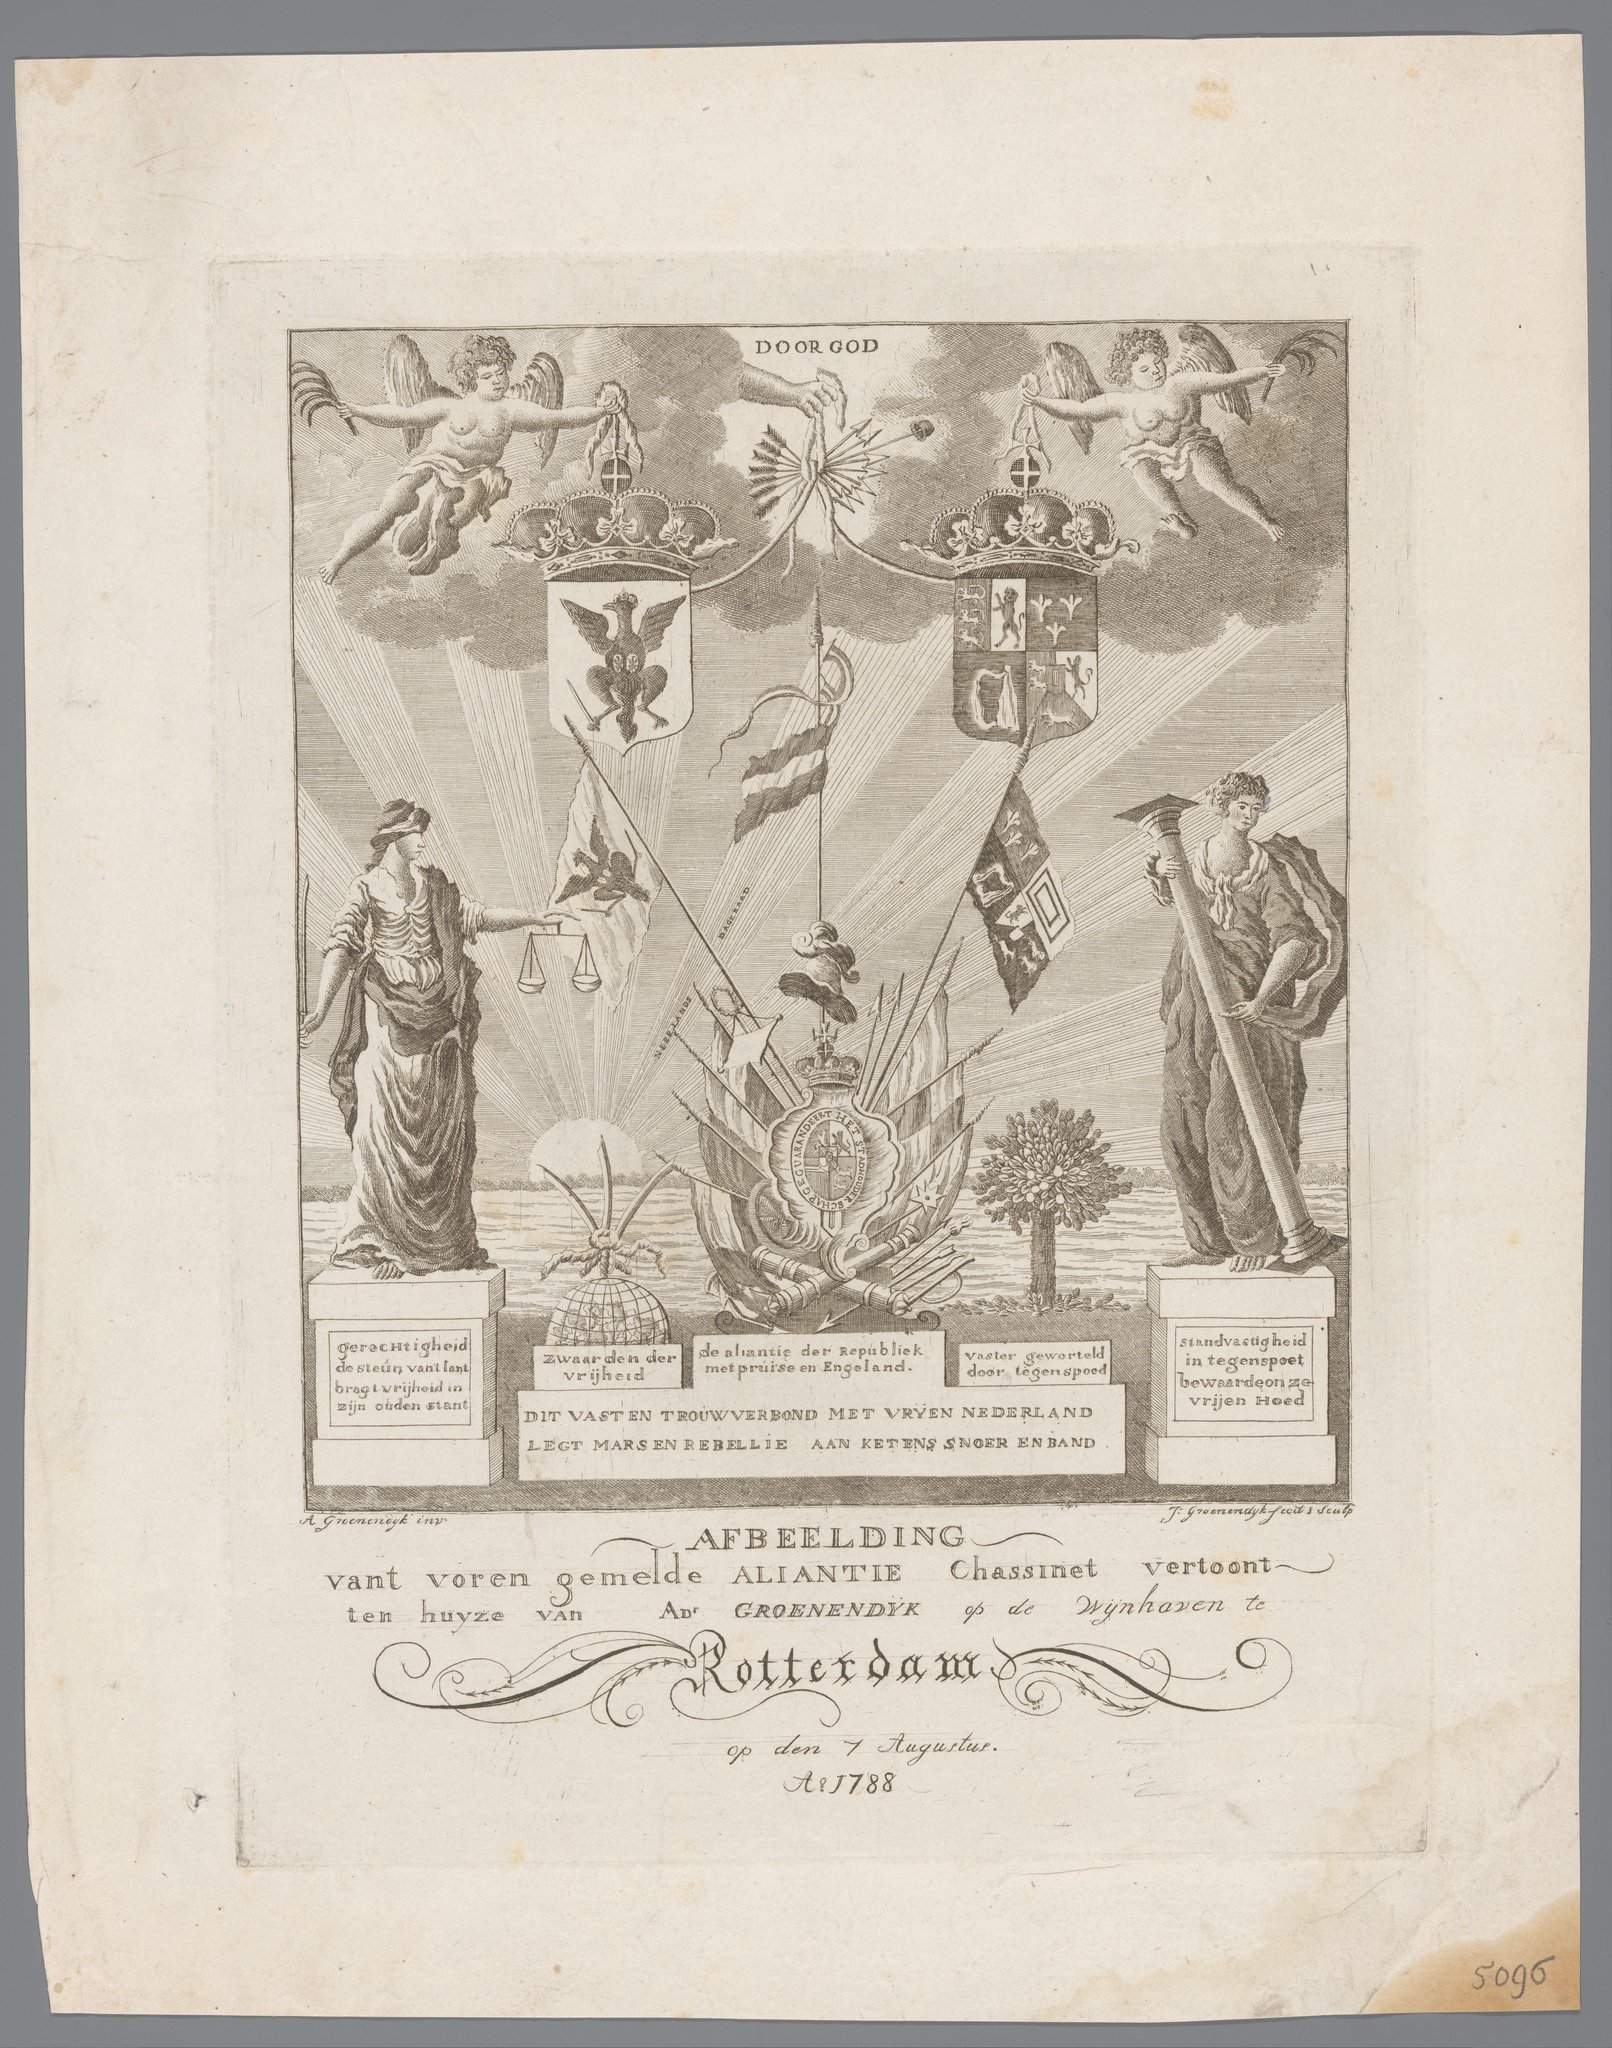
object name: book illustration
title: Afbeelding vant voren gemelde aliantie chassinet vertoont ten huyze van Adr. Groenendijk op de Wijnhaven te Rotterdam op den 7 augustus ao. 1788.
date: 1788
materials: paper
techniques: engraving, etching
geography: rotterdam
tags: berlin, draughtsman, wilhelmina of prussia (princess of orange), fortitude, 'fortitudo' ~ one of the four cardinal virtues, justice, 'justitia'; 'giustitia divina' (ripa) ~ one of the four cardinal virtues, rotterdam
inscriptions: date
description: Chassinet met een allegorische voorstelling van de Triple Alliantie tussen de Republiek, Pruisen en Engeland uit 1788 in rebusvorm. Onderdeel van de illuminatie van het huis van Adriaen Groenendijk te Rotterdam, ter gelegenheid van de verjaardag van prinses Wilhelmina van Pruisen op 7 augustus 1788.